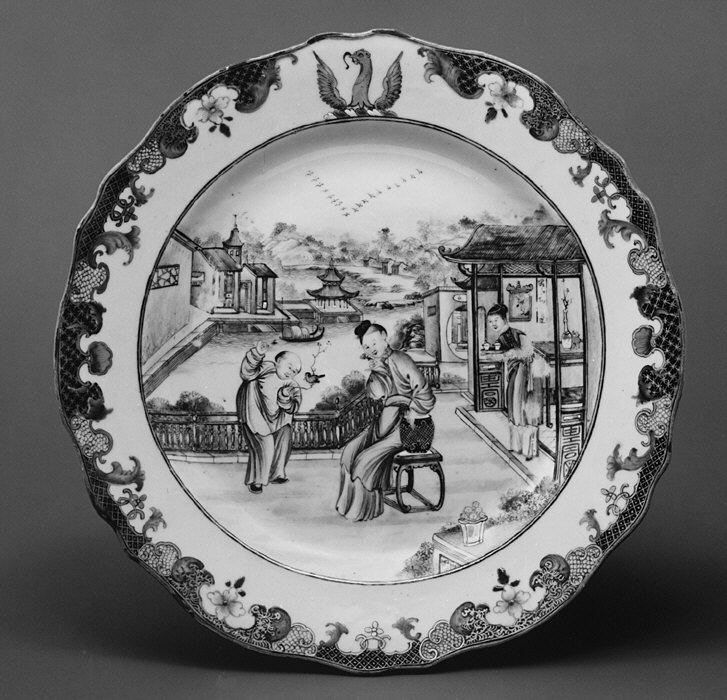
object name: plate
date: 1770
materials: hard paste porcelain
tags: birds,men,women